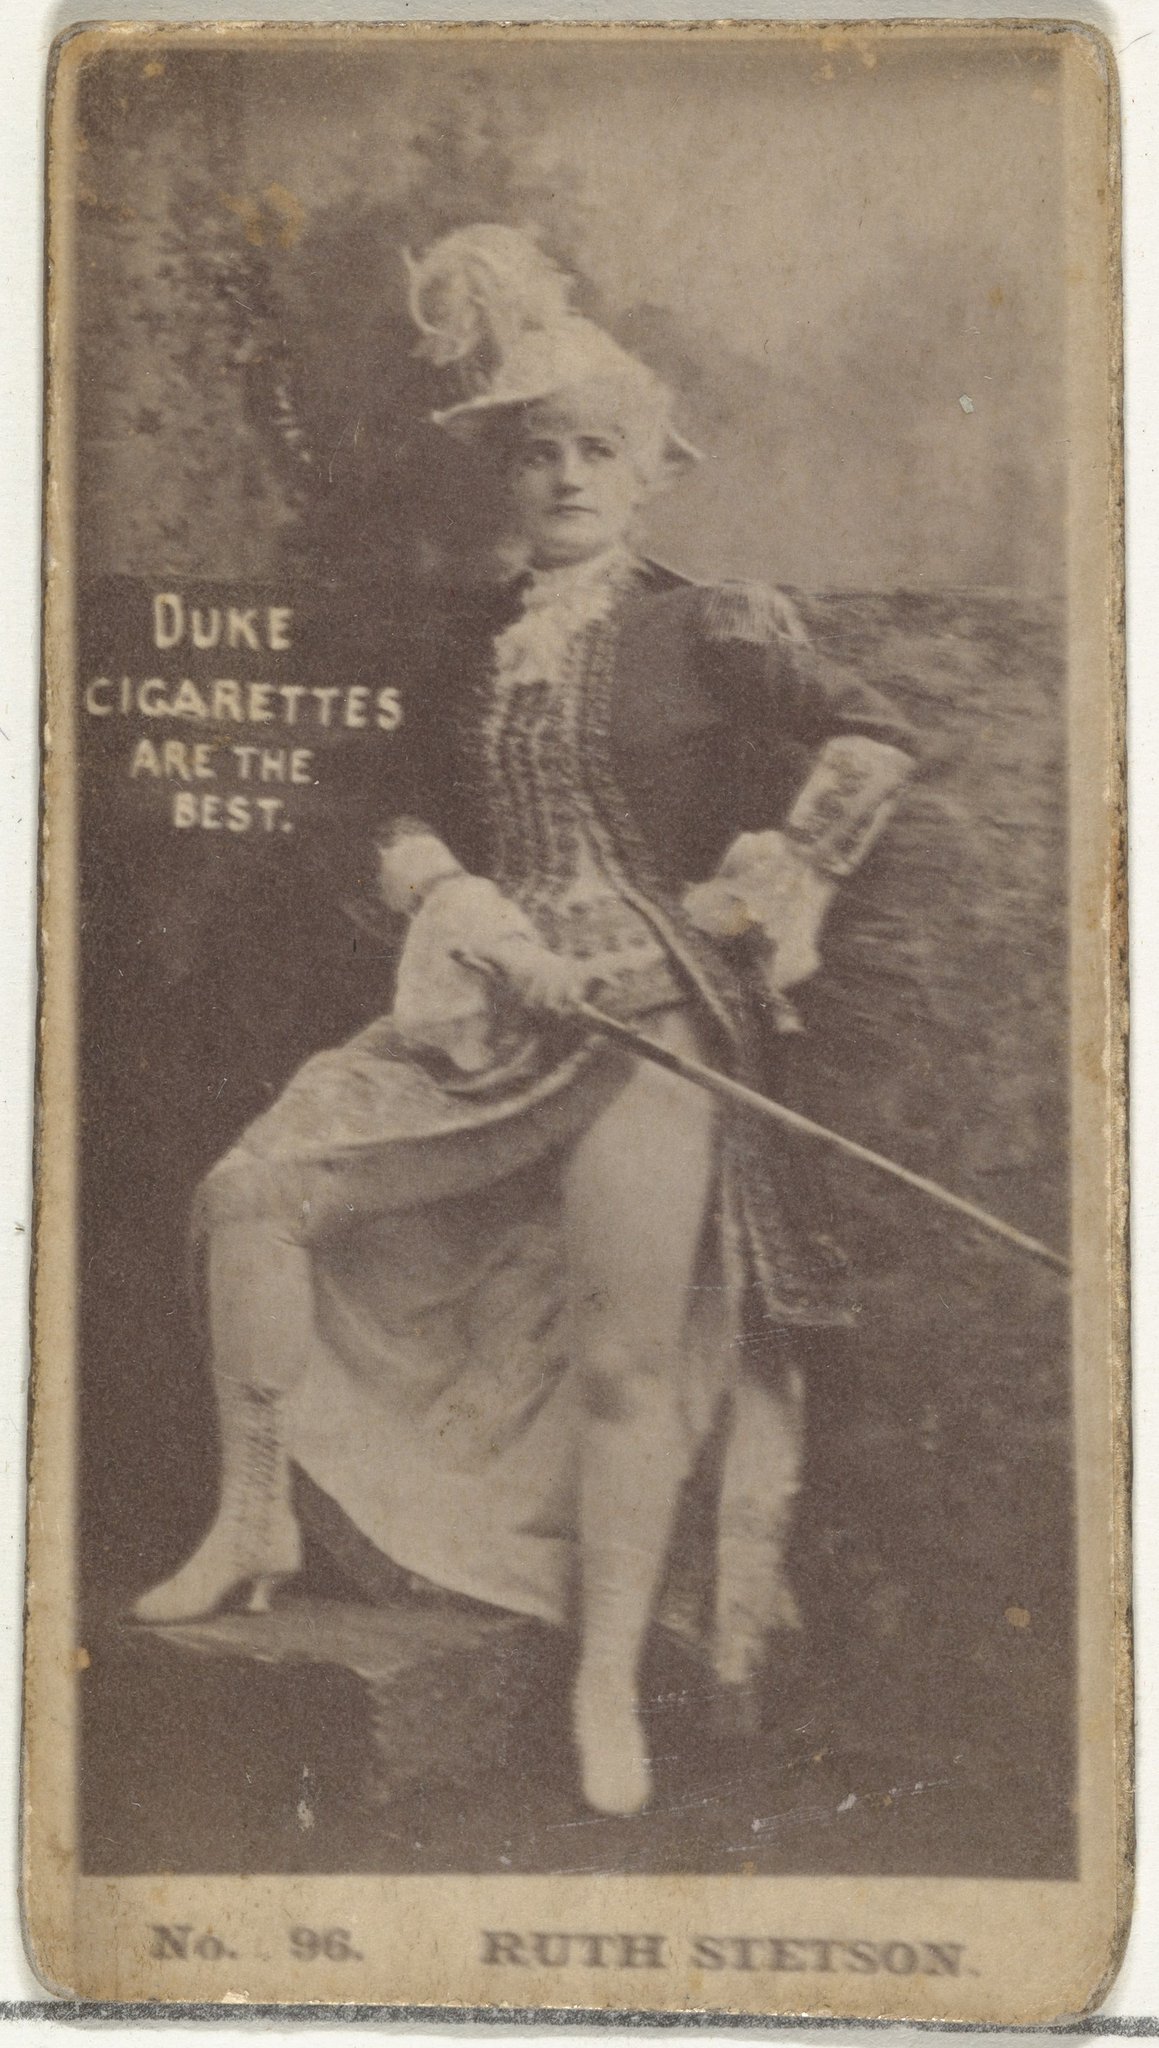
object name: photograph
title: Card Number 96, Ruth Stetson, from the Actors and Actresses series (N145-6) issued by Duke Sons & Co. to promote Duke Cigarettes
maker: w. duke, sons & co.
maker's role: publisher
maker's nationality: american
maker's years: 1870-1920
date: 1880-1889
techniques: albumen silver print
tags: portraits,women,actresses